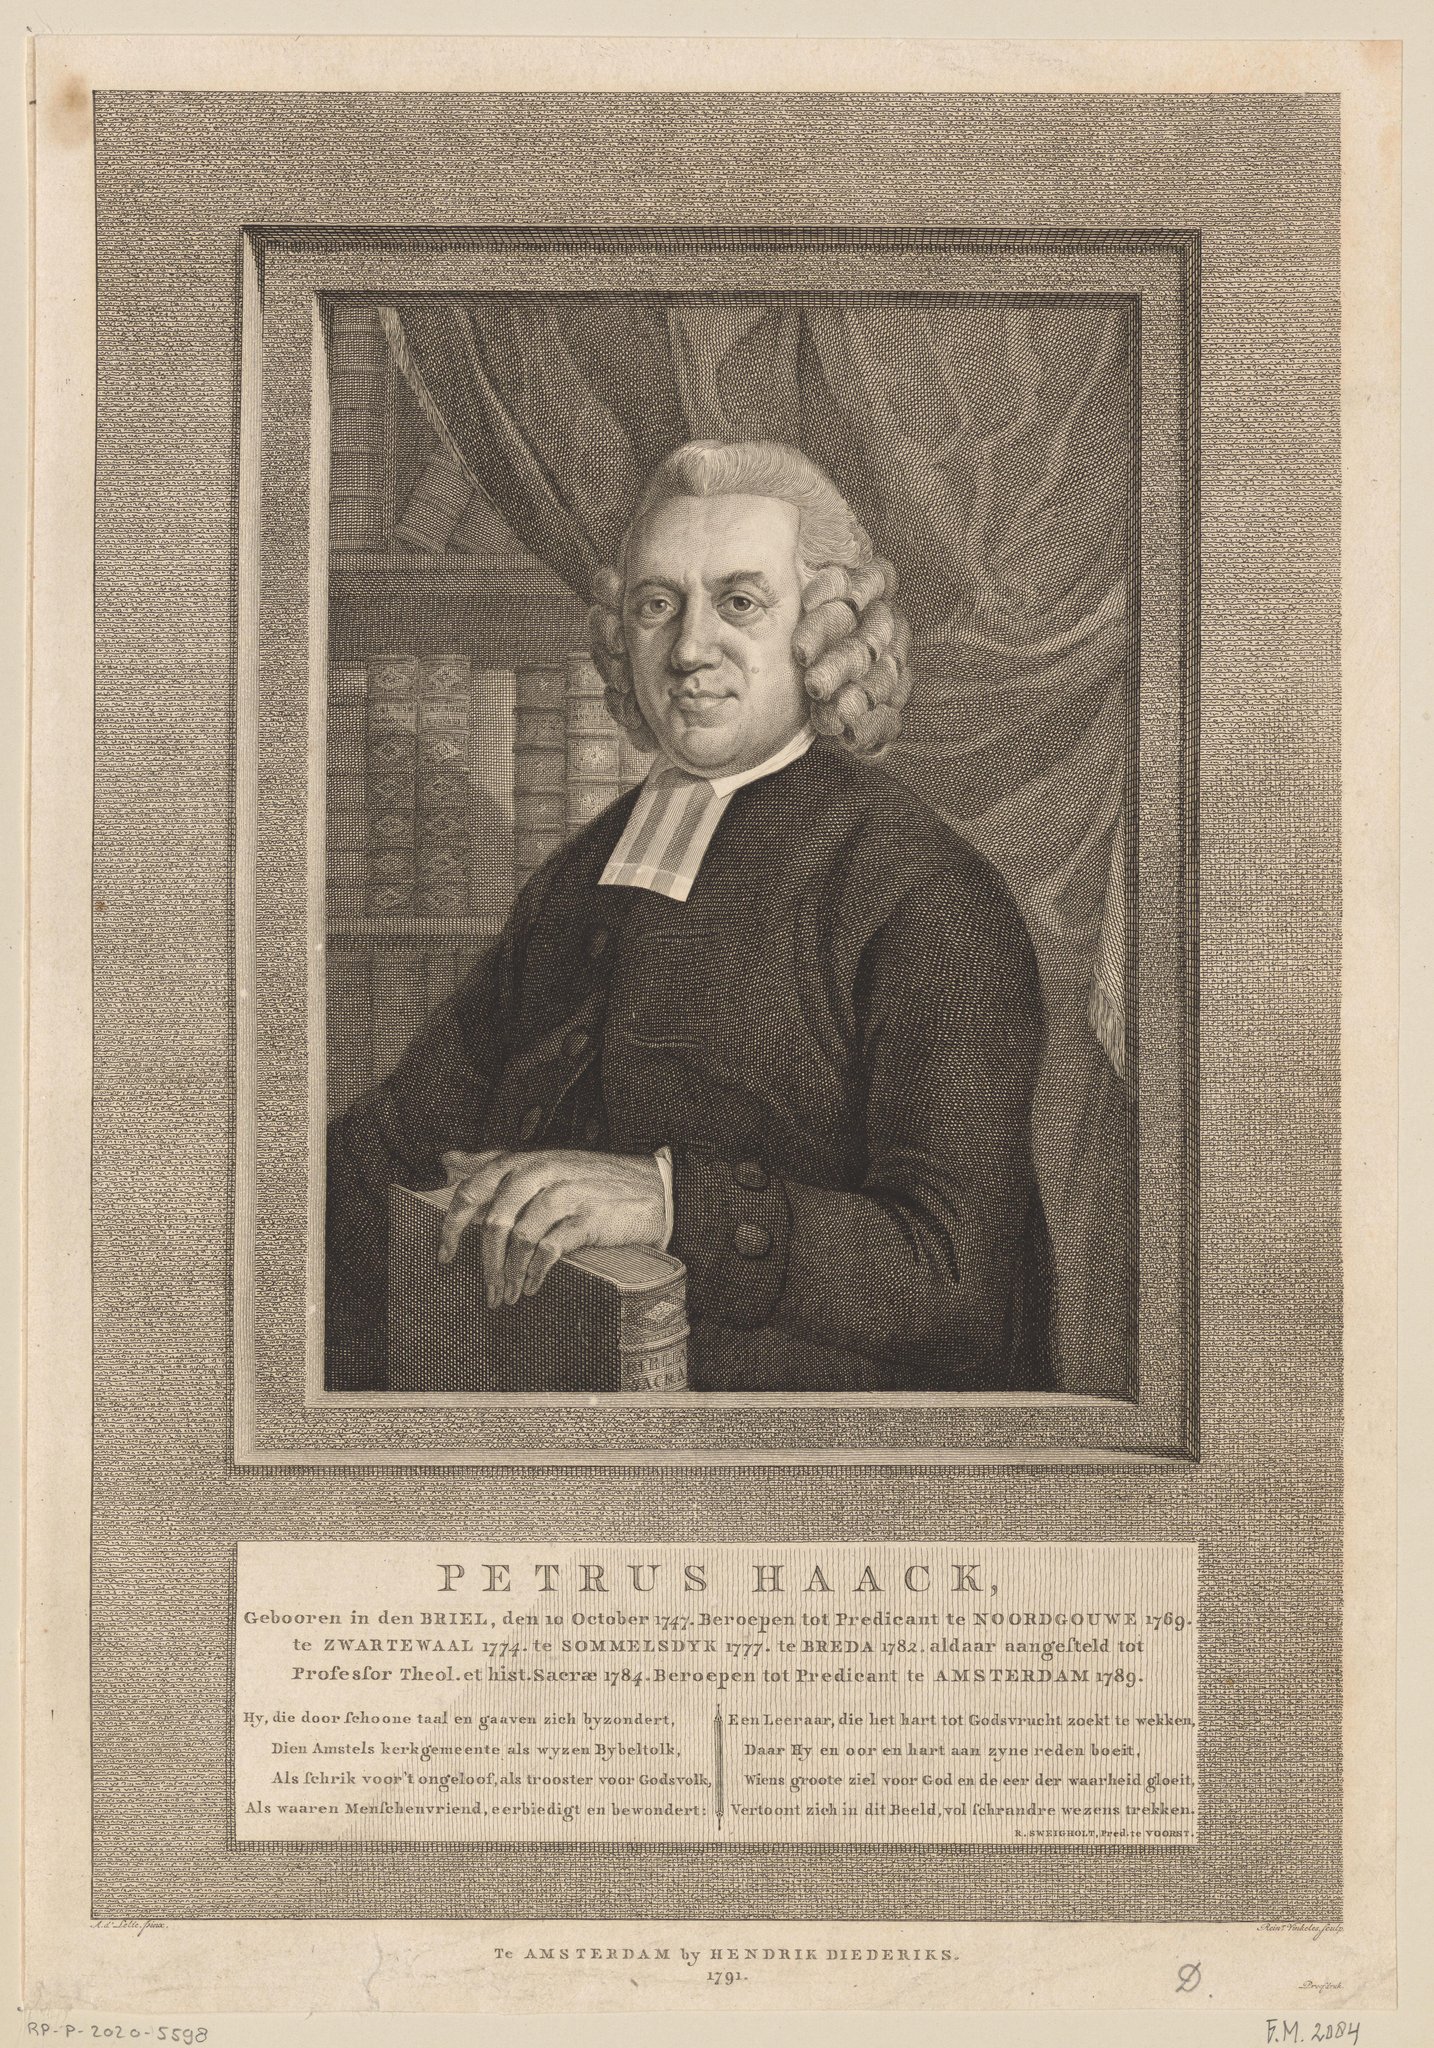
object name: print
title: Portret van Petrus Haack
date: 1791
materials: paper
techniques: engraving, etching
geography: amsterdam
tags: petrus haack, historical persons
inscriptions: collector's mark: Lugt 240